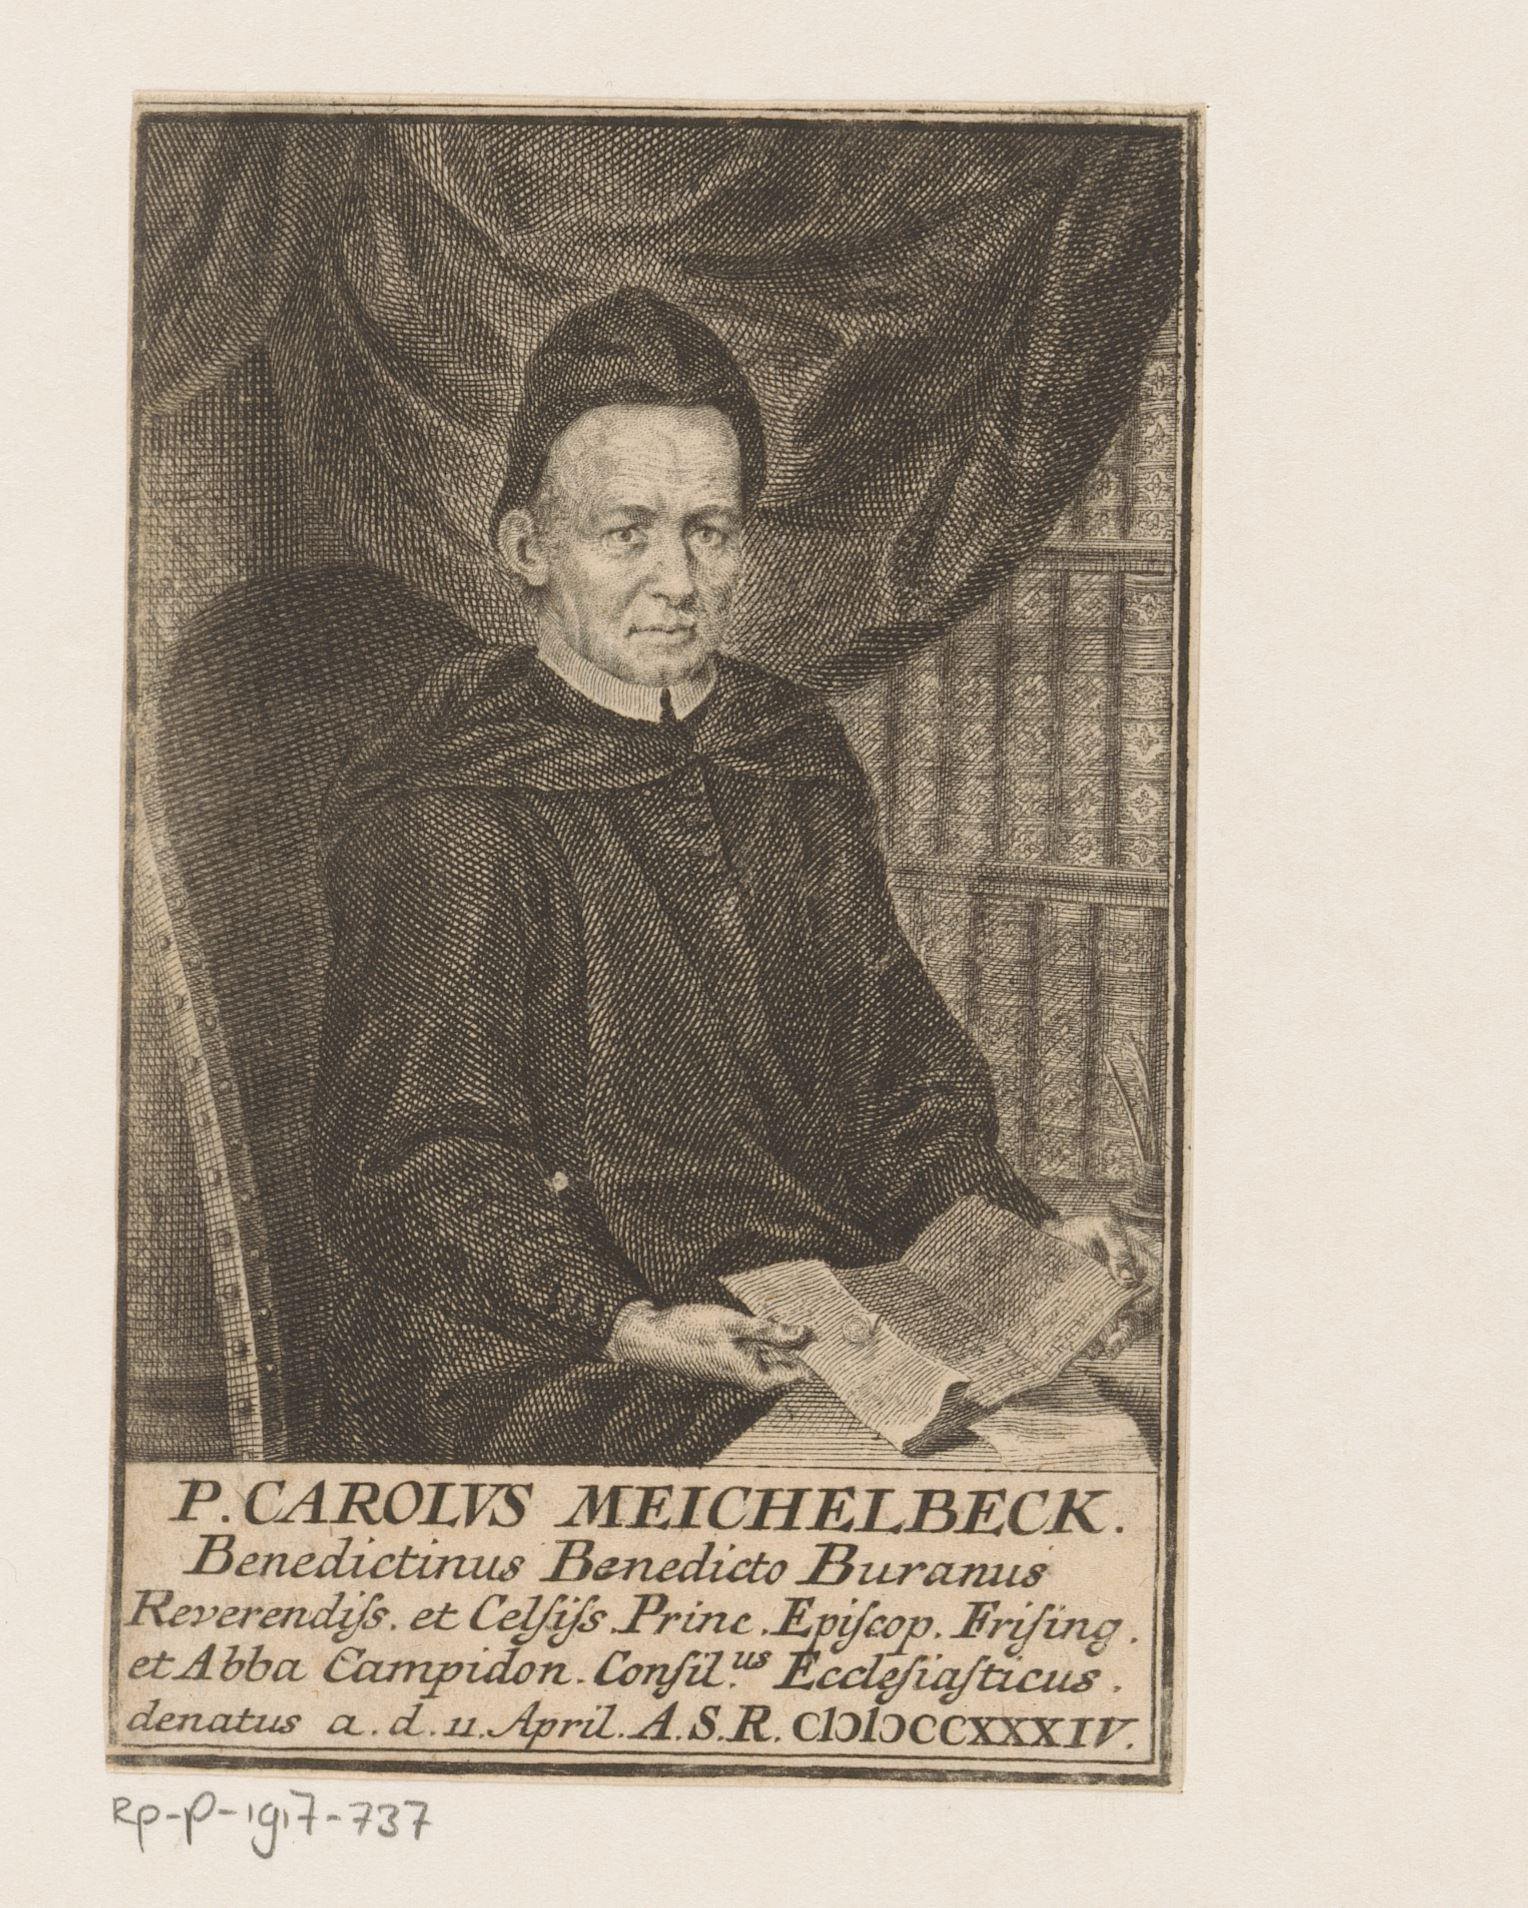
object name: print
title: Portret van Karl Meichelbeck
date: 1734-1779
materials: paper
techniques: engraving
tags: bookshelves, historical persons, letter, envelope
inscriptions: collector's mark: Lugt 2228